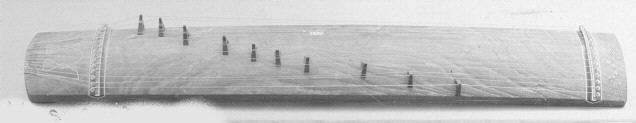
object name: koto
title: Koto (箏)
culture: japanese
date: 1801-1900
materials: ivory, metal, silk, wood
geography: japan